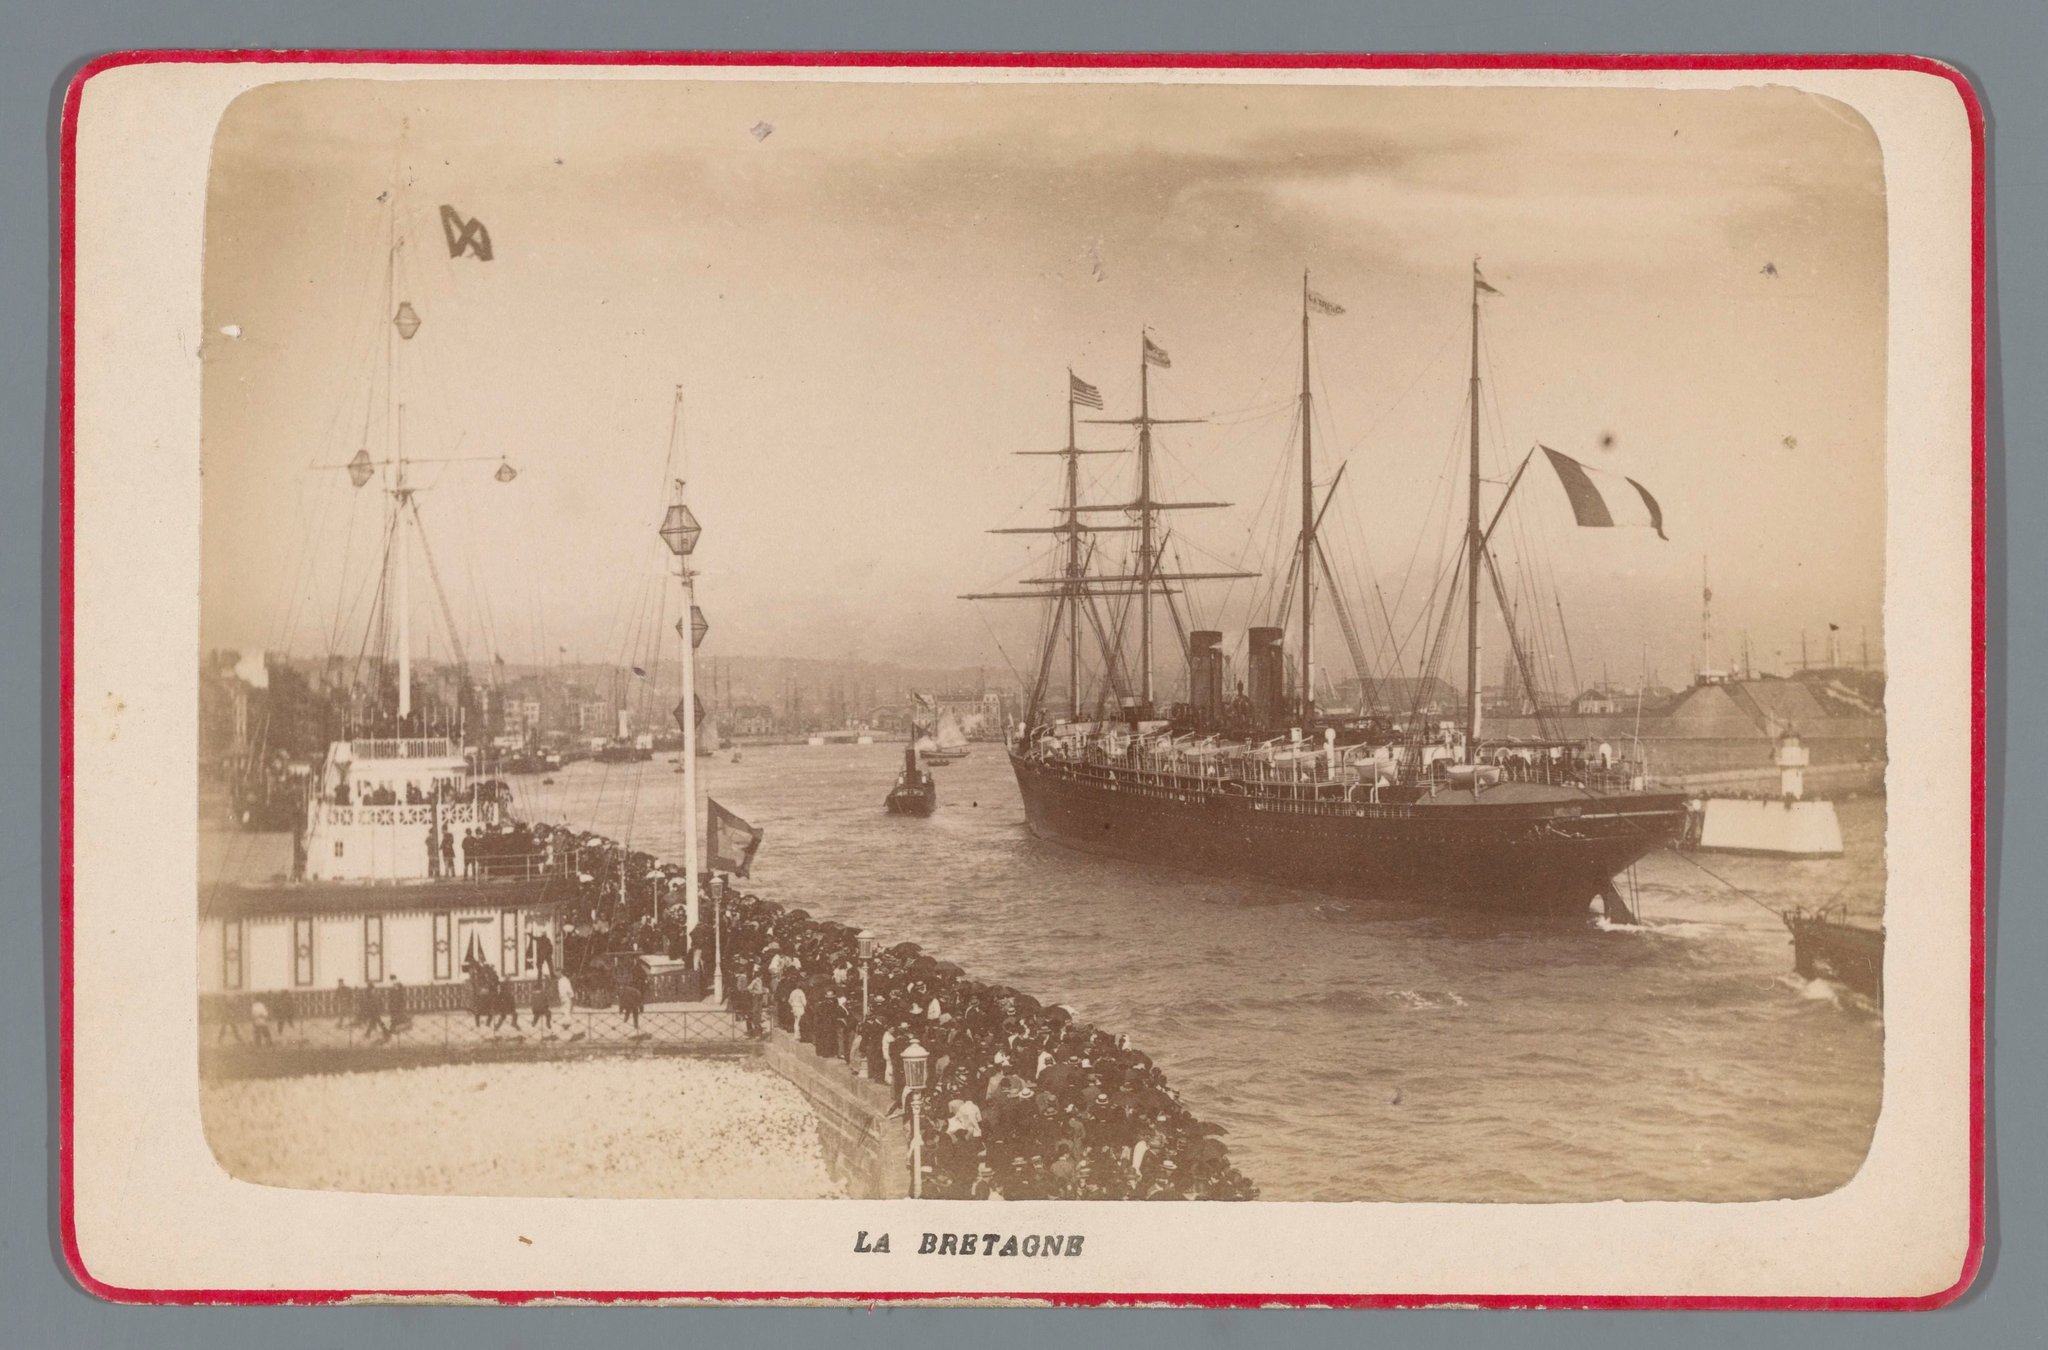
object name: photograph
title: La Bretagne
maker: Anonymous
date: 1893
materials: cardboard, photographic support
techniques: albumen print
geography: le havre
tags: harbour, ships (in general), le havre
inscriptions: date: ‘12 Août 1893’, annotation: ‘Le Havre’